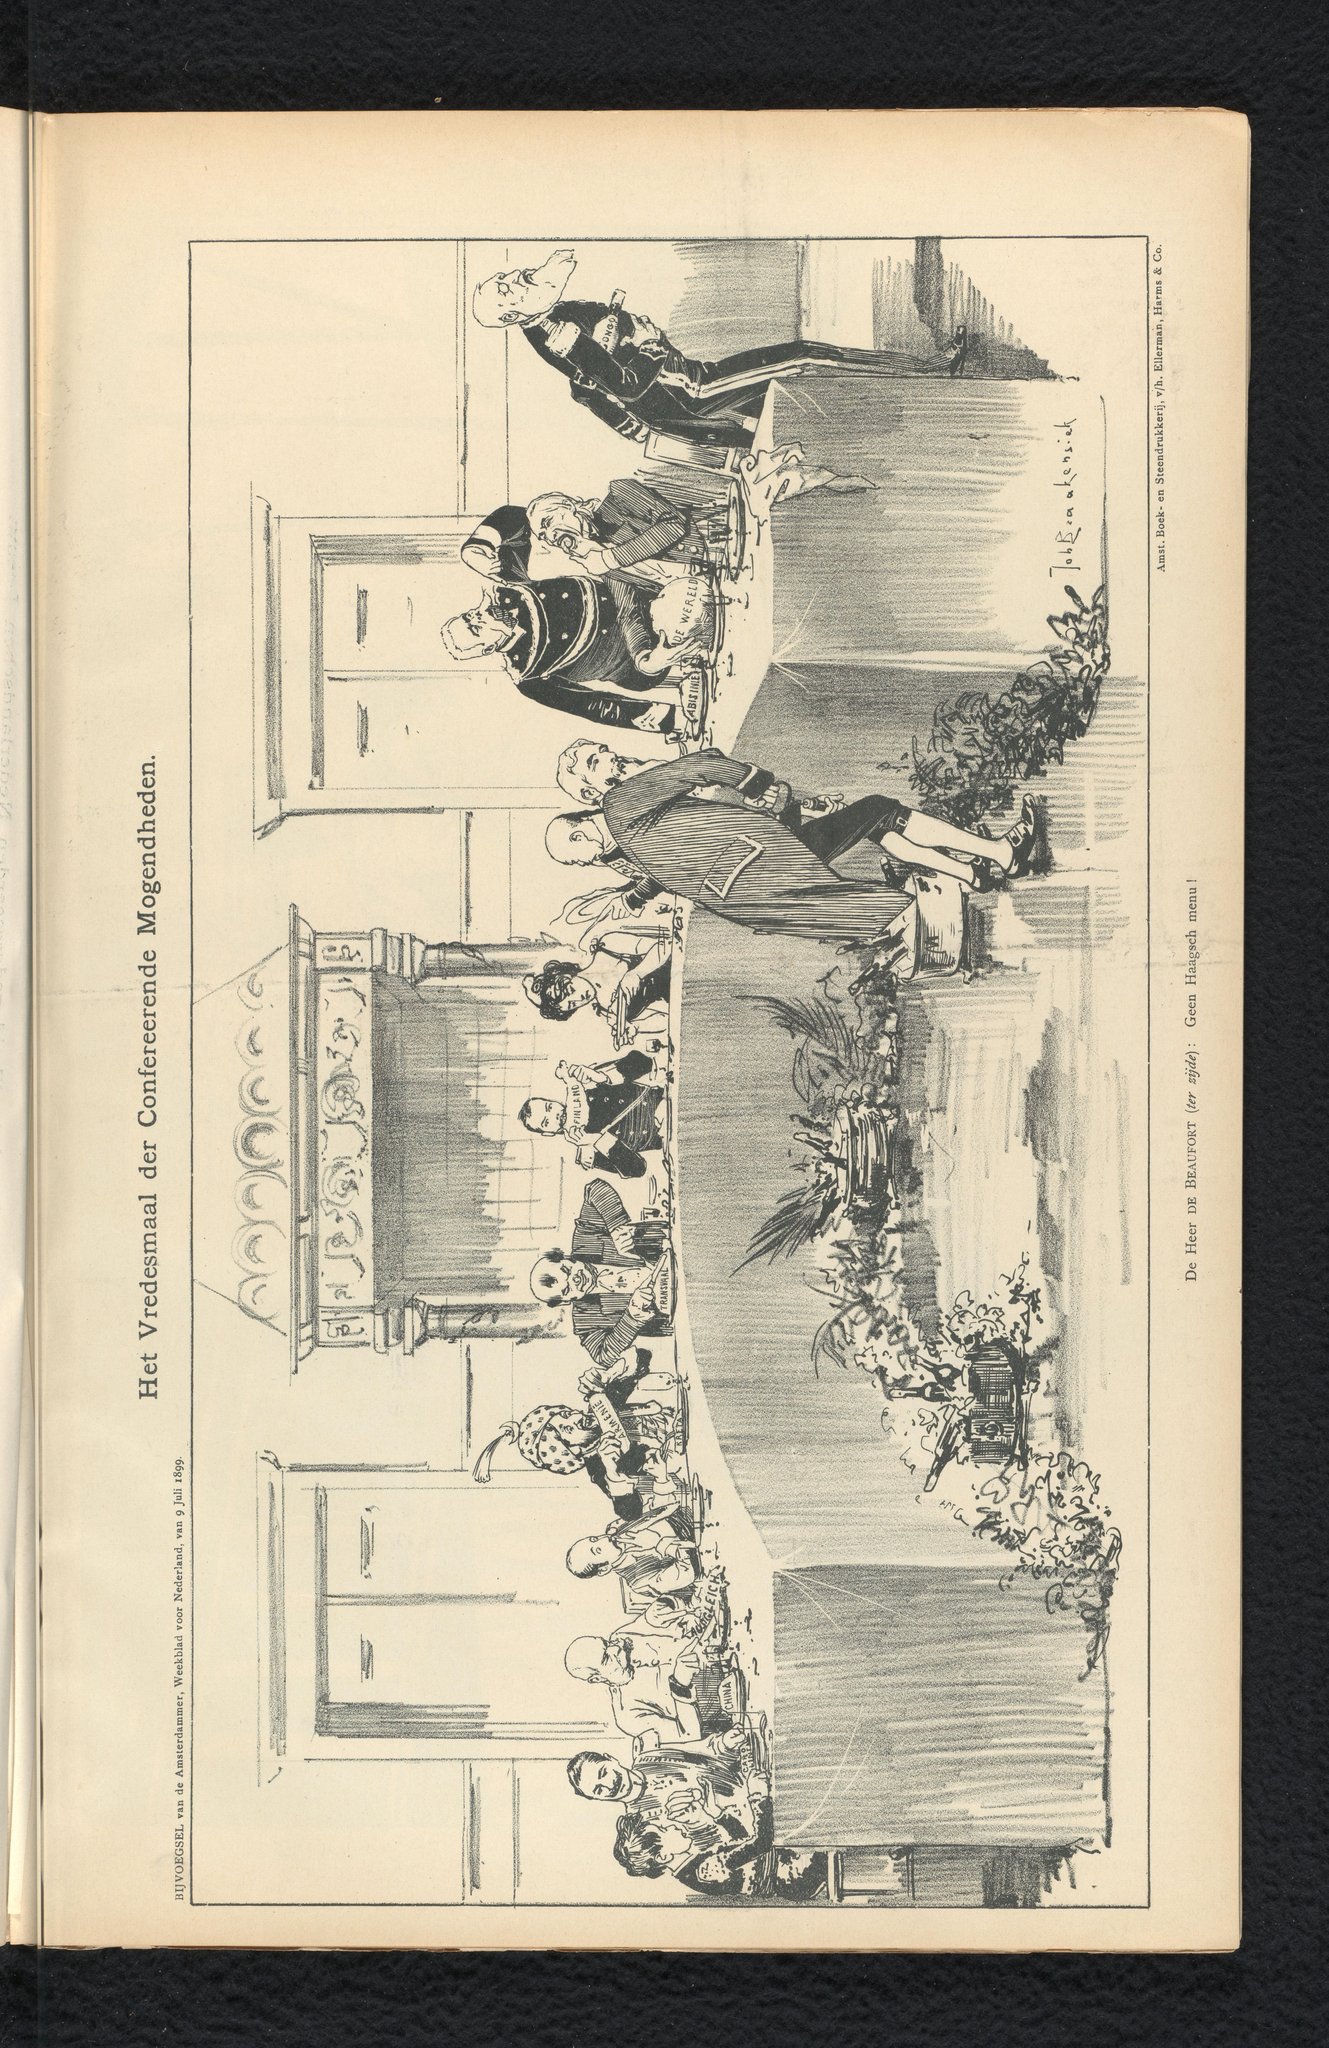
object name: cartoon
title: Het Vredesmaal der Confereerende Mogendheden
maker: johan braakensiek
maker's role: draughtsman, print maker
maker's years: 1858-1940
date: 1899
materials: paper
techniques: lithograph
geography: amsterdam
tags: the hague, colonial system, imperialism, personifications of countries, nations, states, districts, etc., celebration meal, feast, banquet, negotiations, conference ~ diplomacy, political caricatures and satires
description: De grote mogendheden gezeten aan een tafel verslinden hun koloniën als gerechten van de maaltijd. Minister De Beaufort trekt als kelner een fles wijn open. Naar aanleiding van de Hoogse vredesconferentie.